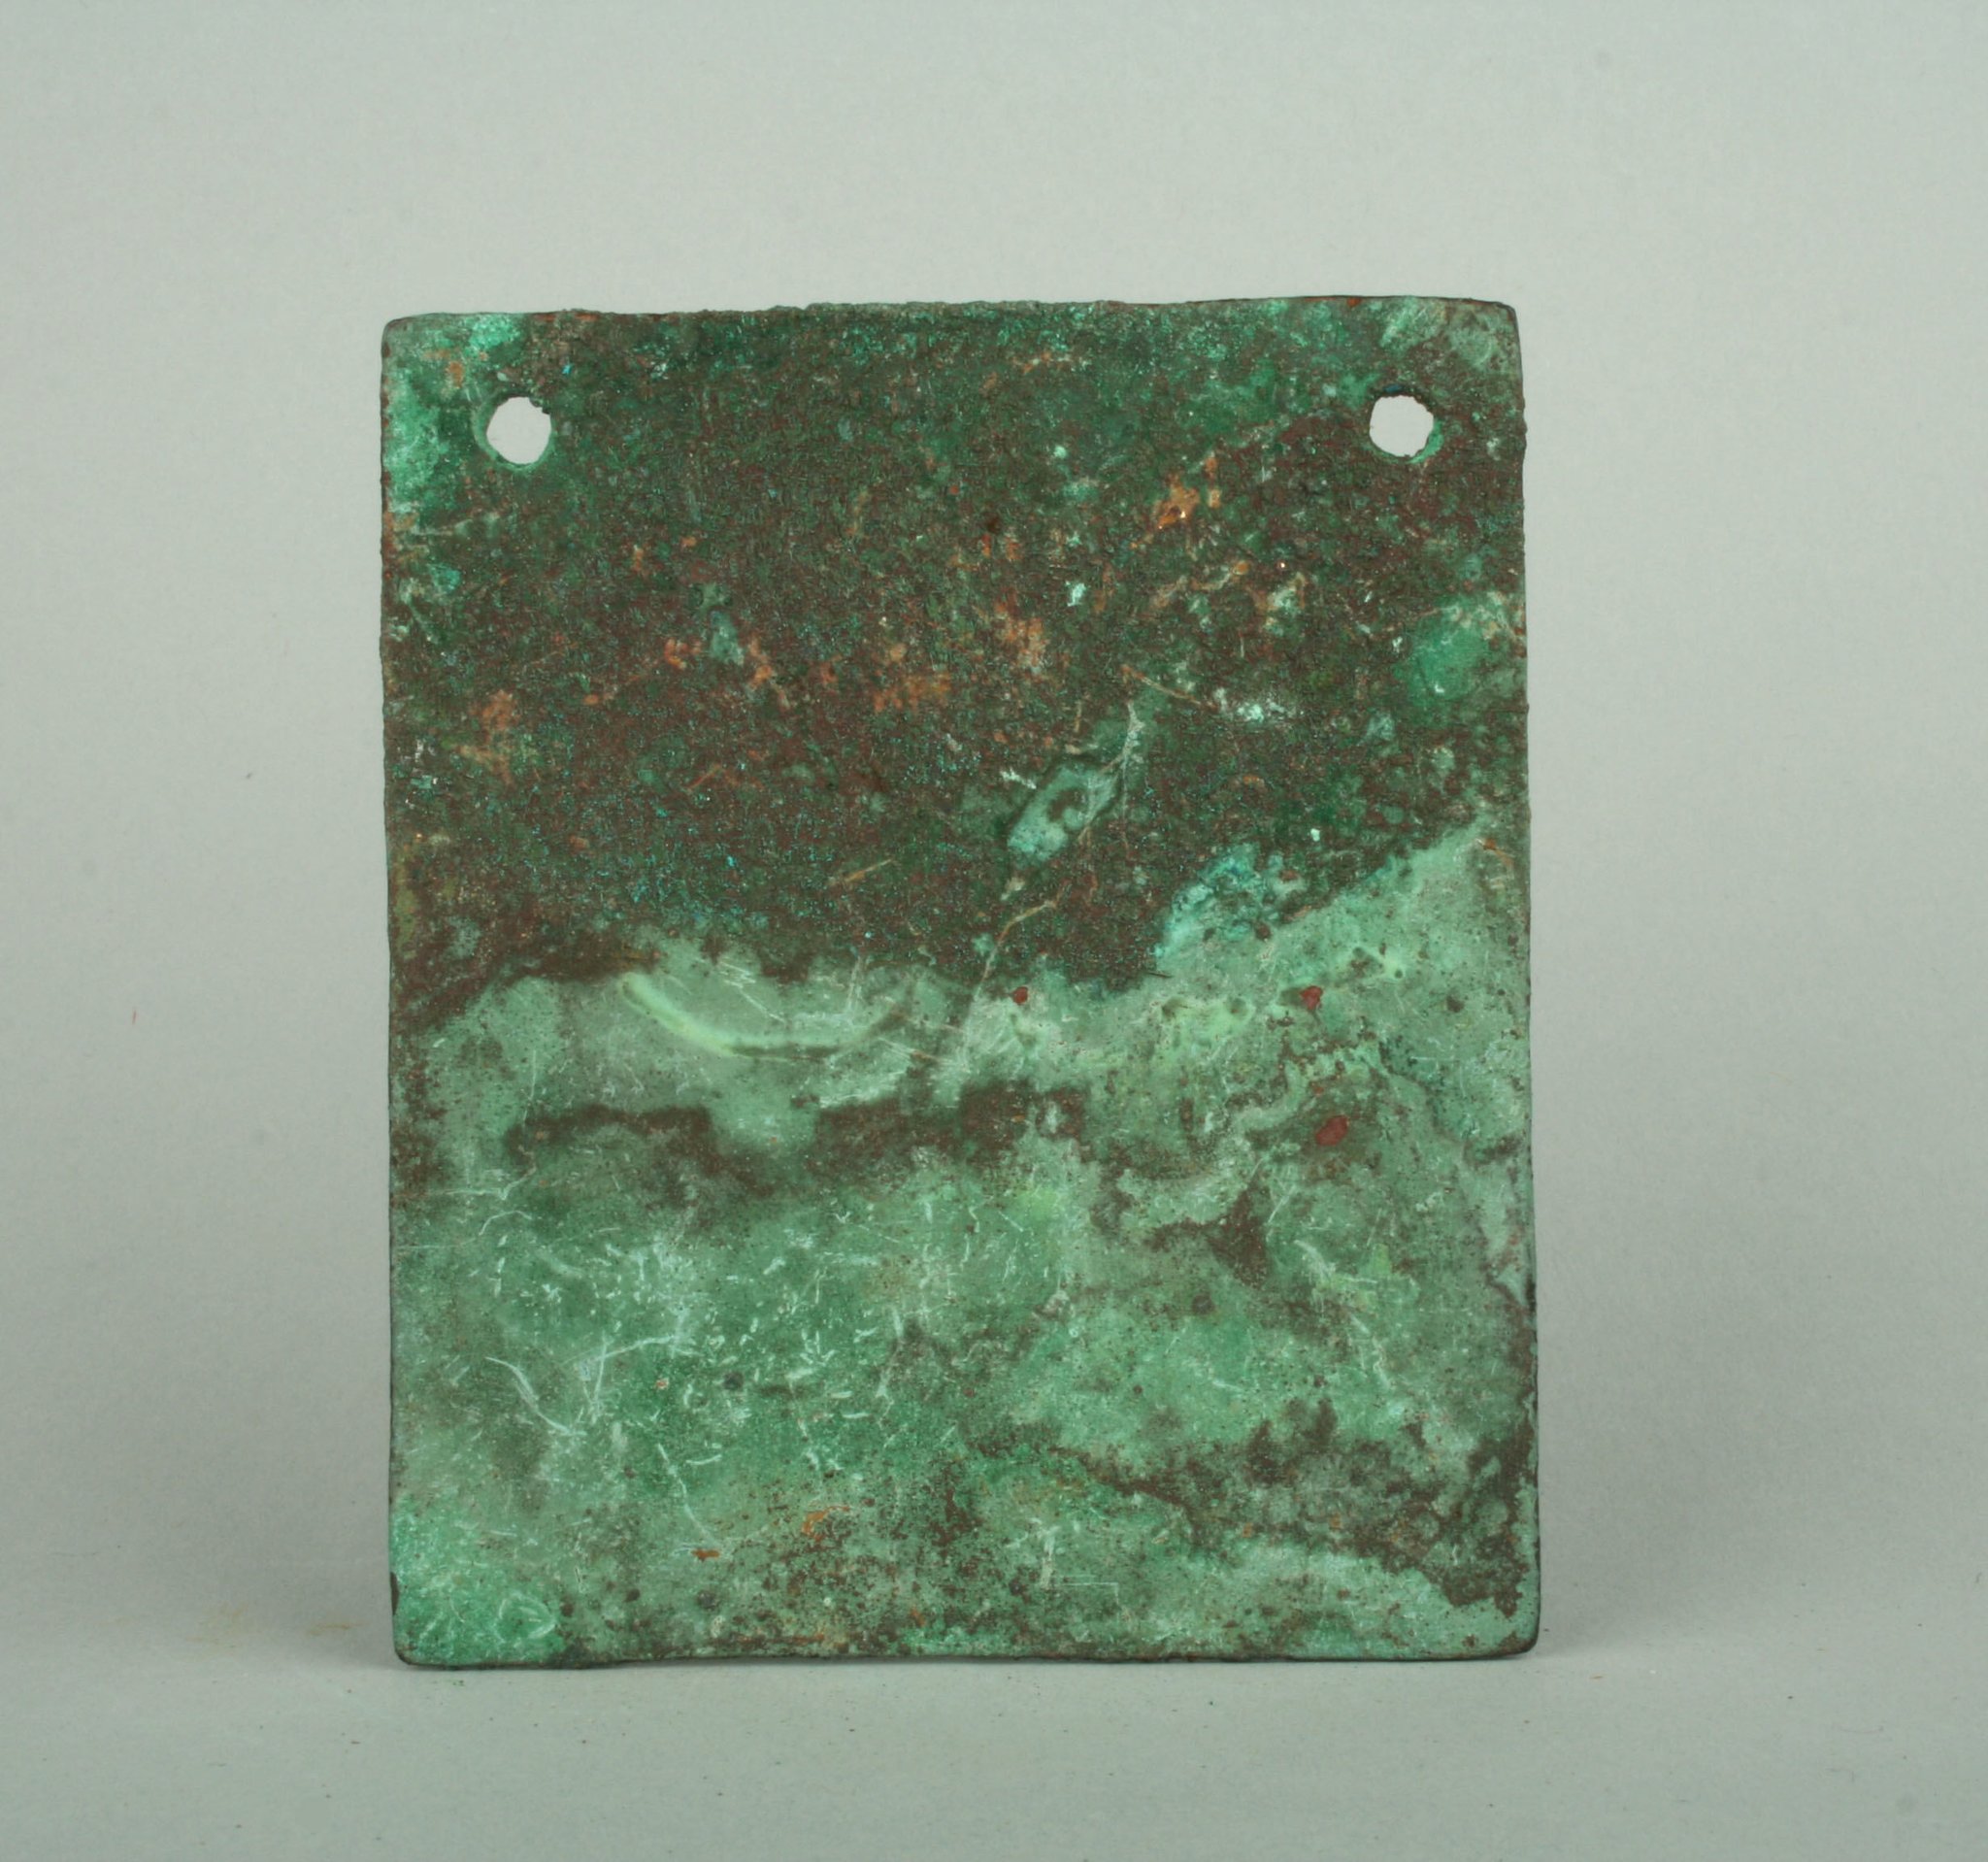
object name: plaque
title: Square Plaque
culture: vicús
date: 300 BCE-200 CE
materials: copper, gilt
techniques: hammering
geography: peru